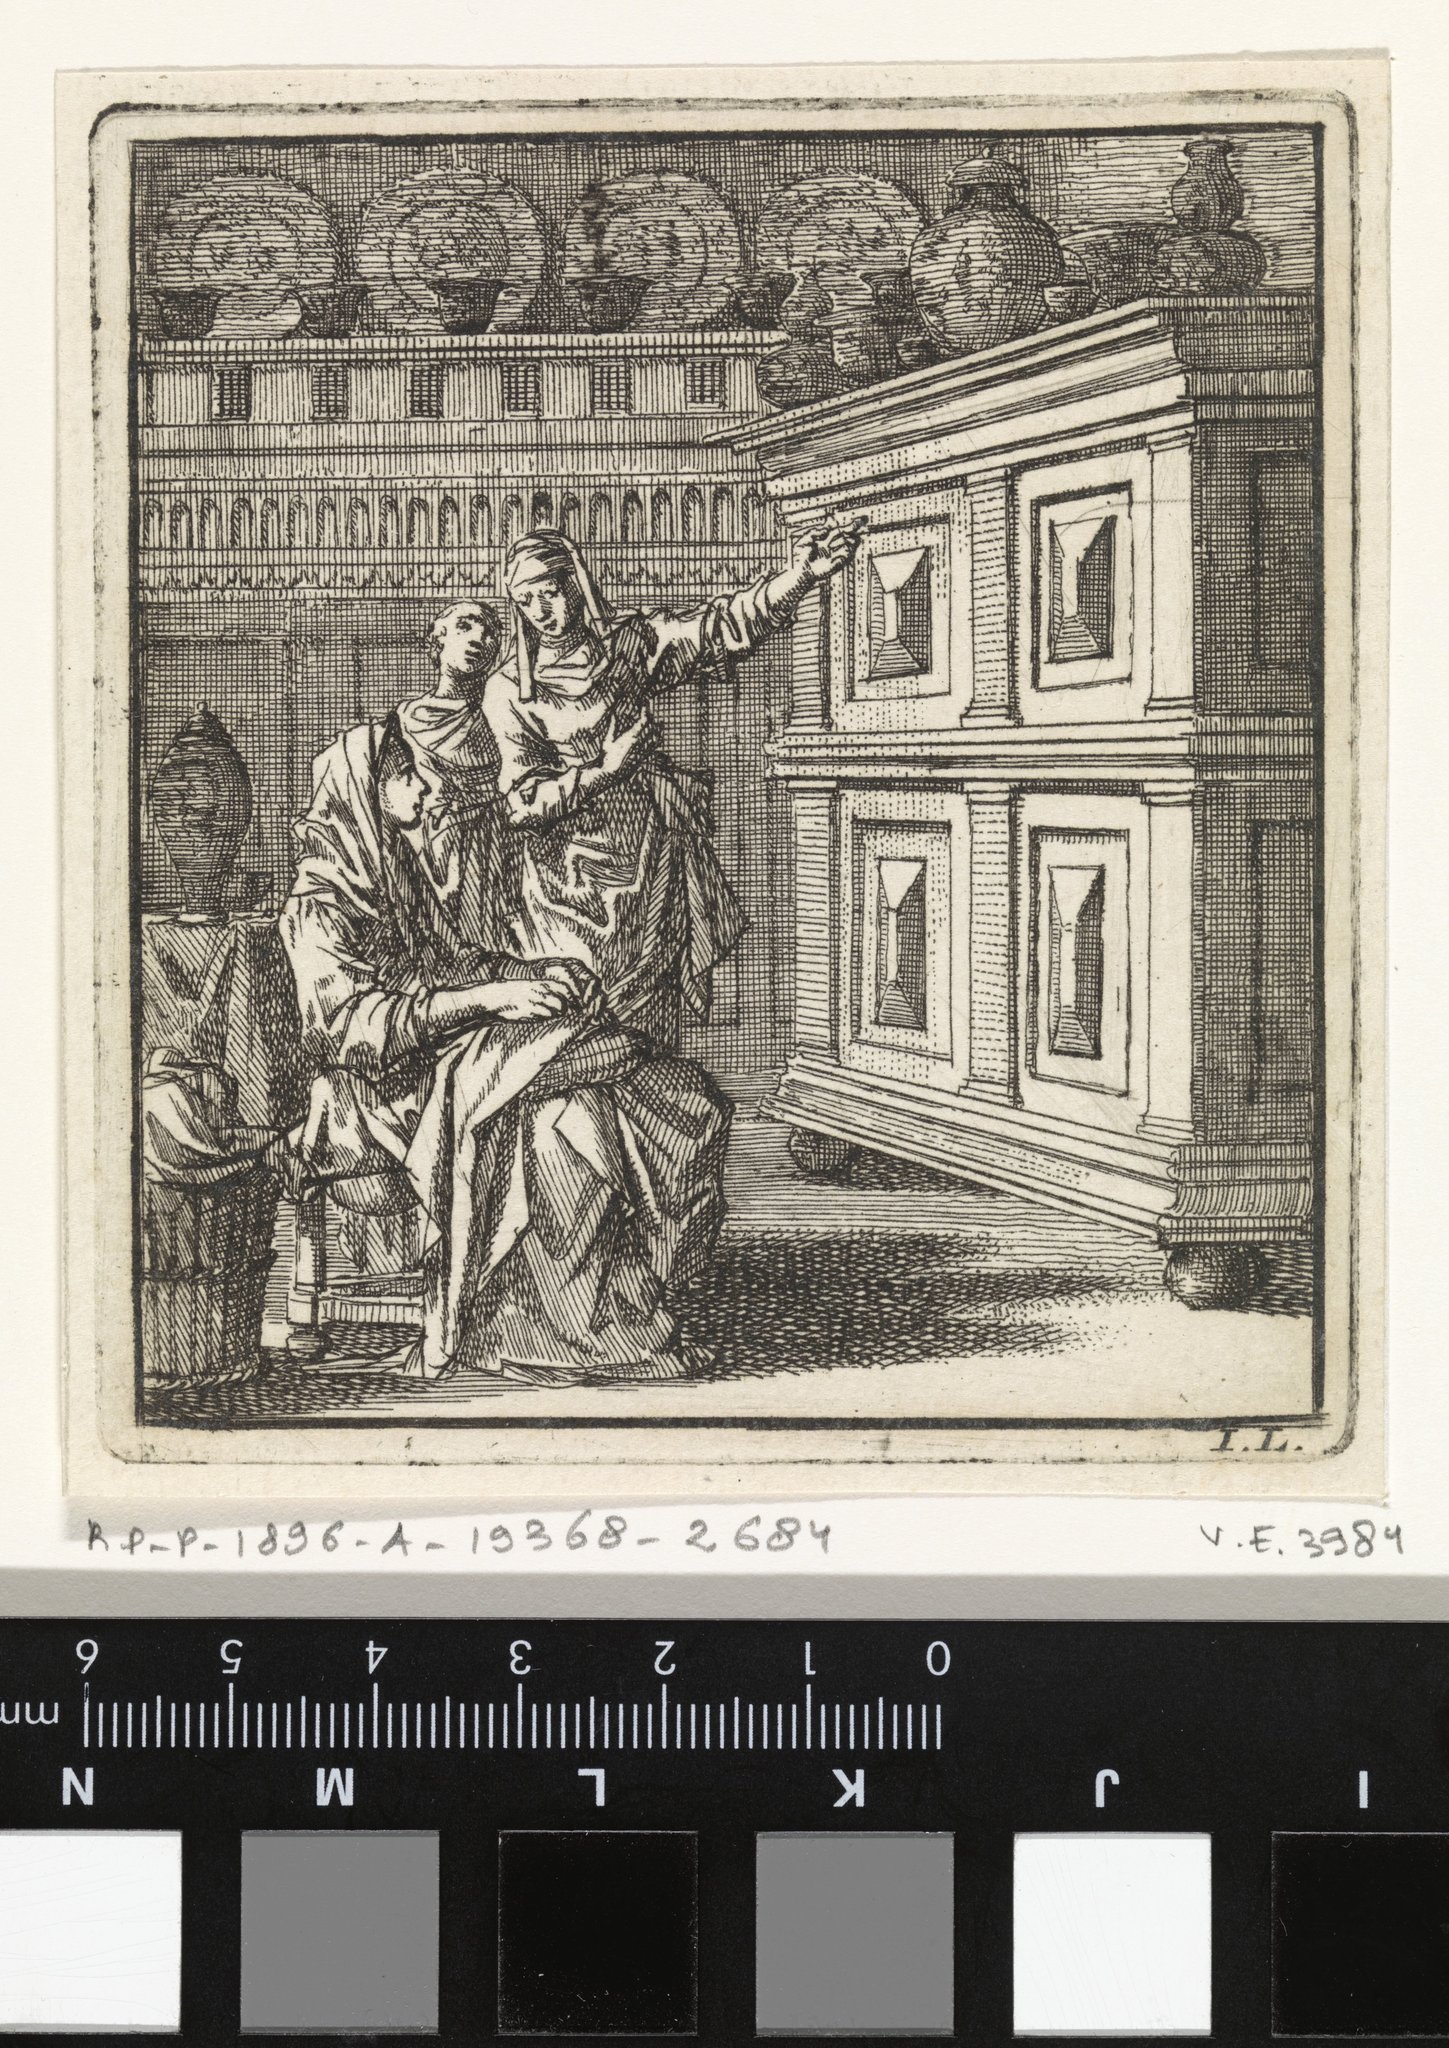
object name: book illustration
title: Het Porselyn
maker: jan luyken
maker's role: draughtsman, print maker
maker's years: 1649-1712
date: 1711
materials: paper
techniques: etching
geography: amsterdam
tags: vase ~ ornament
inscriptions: collector's mark: Lugt 2228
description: Illustratie voor: Luyken, Jan. Het leerzaam huisraad, vertoond in vyftig konstige figuuren, met godlyke spreuken en stichtelyke verzen: Pieter Arentsz. II (wed.) en Cornelis van der Sys, 1711, p. 118.